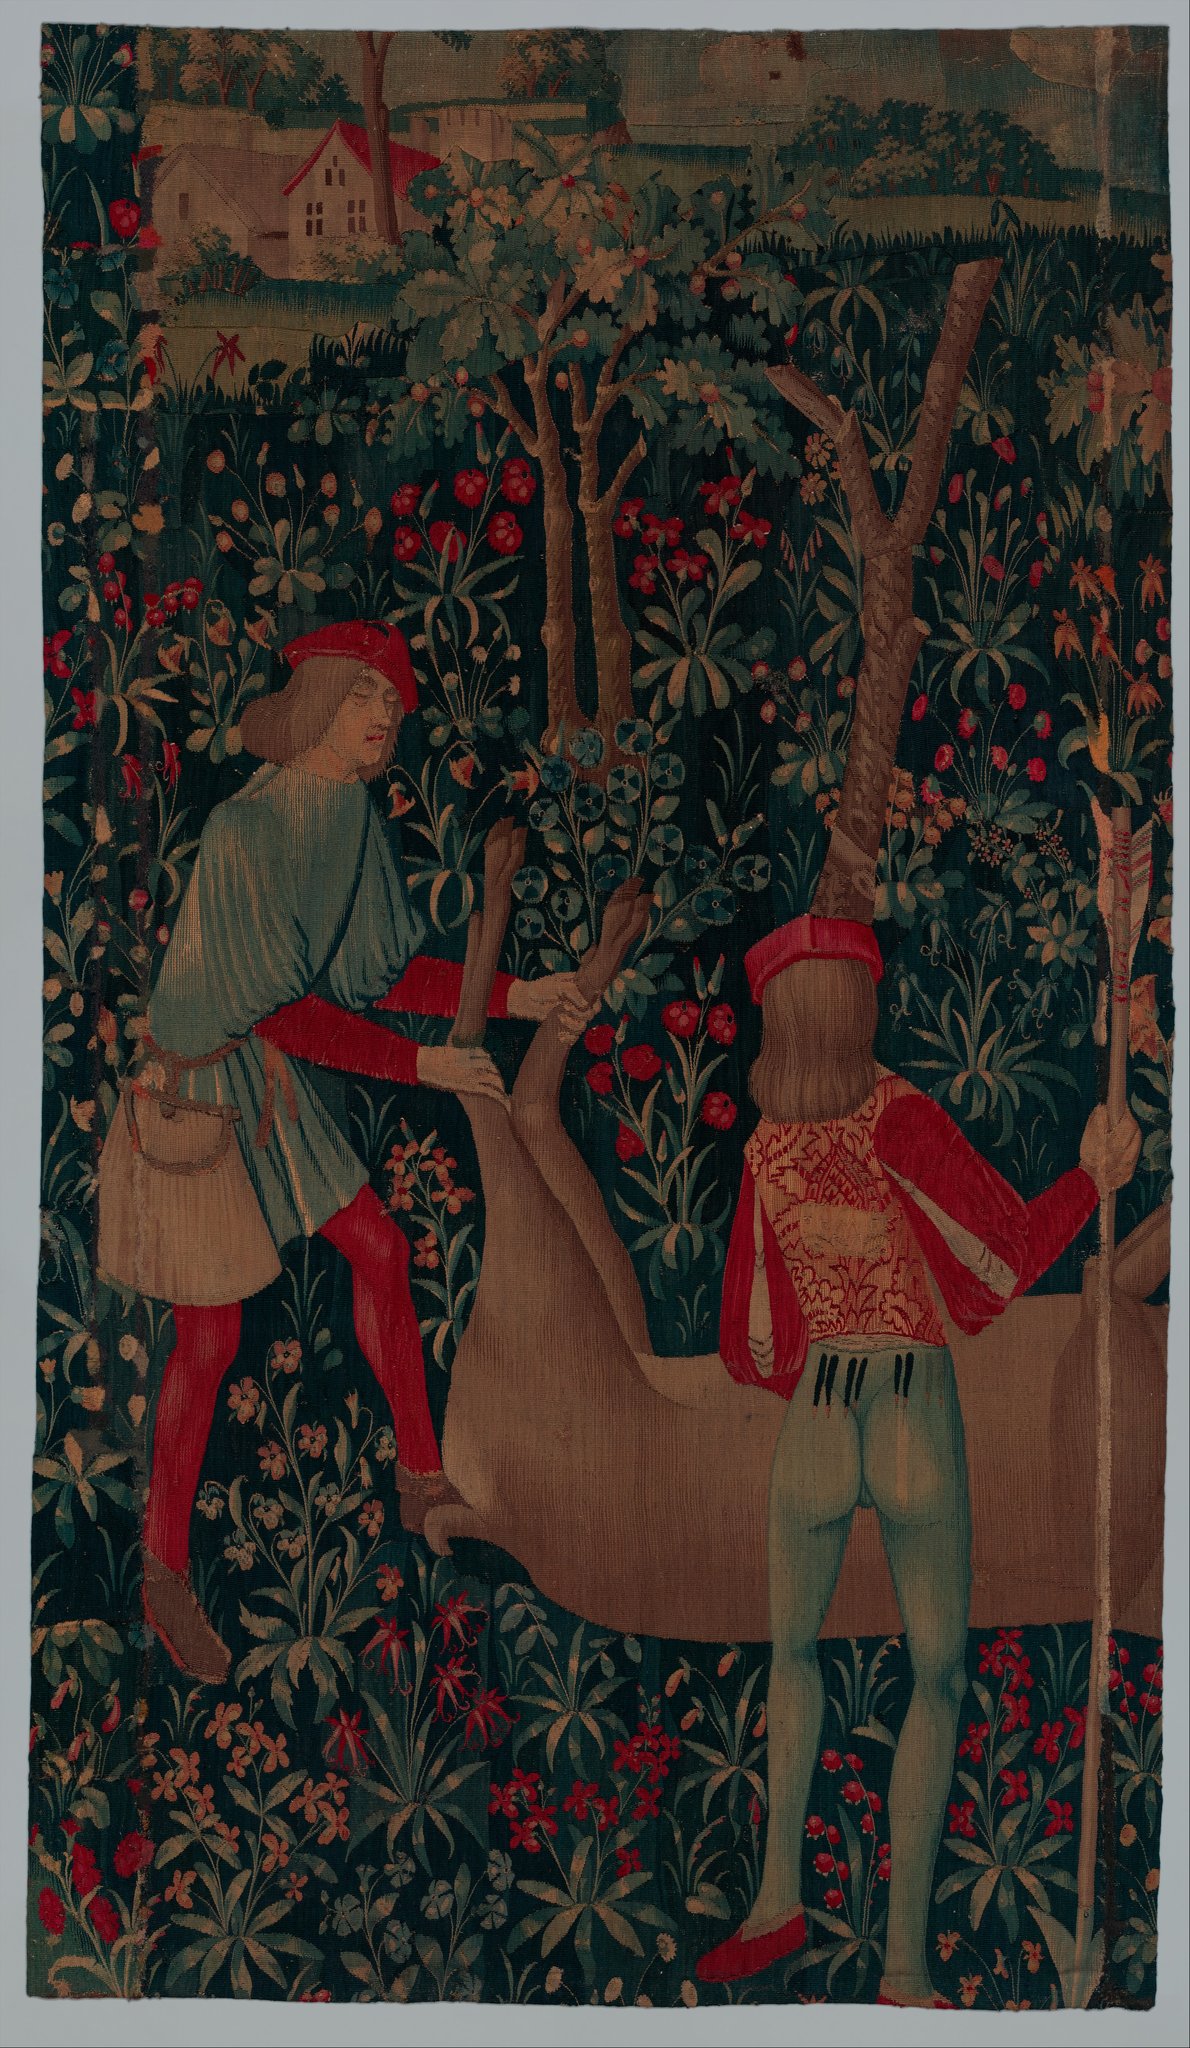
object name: tapestry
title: Rewarding the Hounds (From Incidents in a Stag Hunt)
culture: south netherlandish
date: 1495-1515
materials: wool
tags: men,deer,flowers